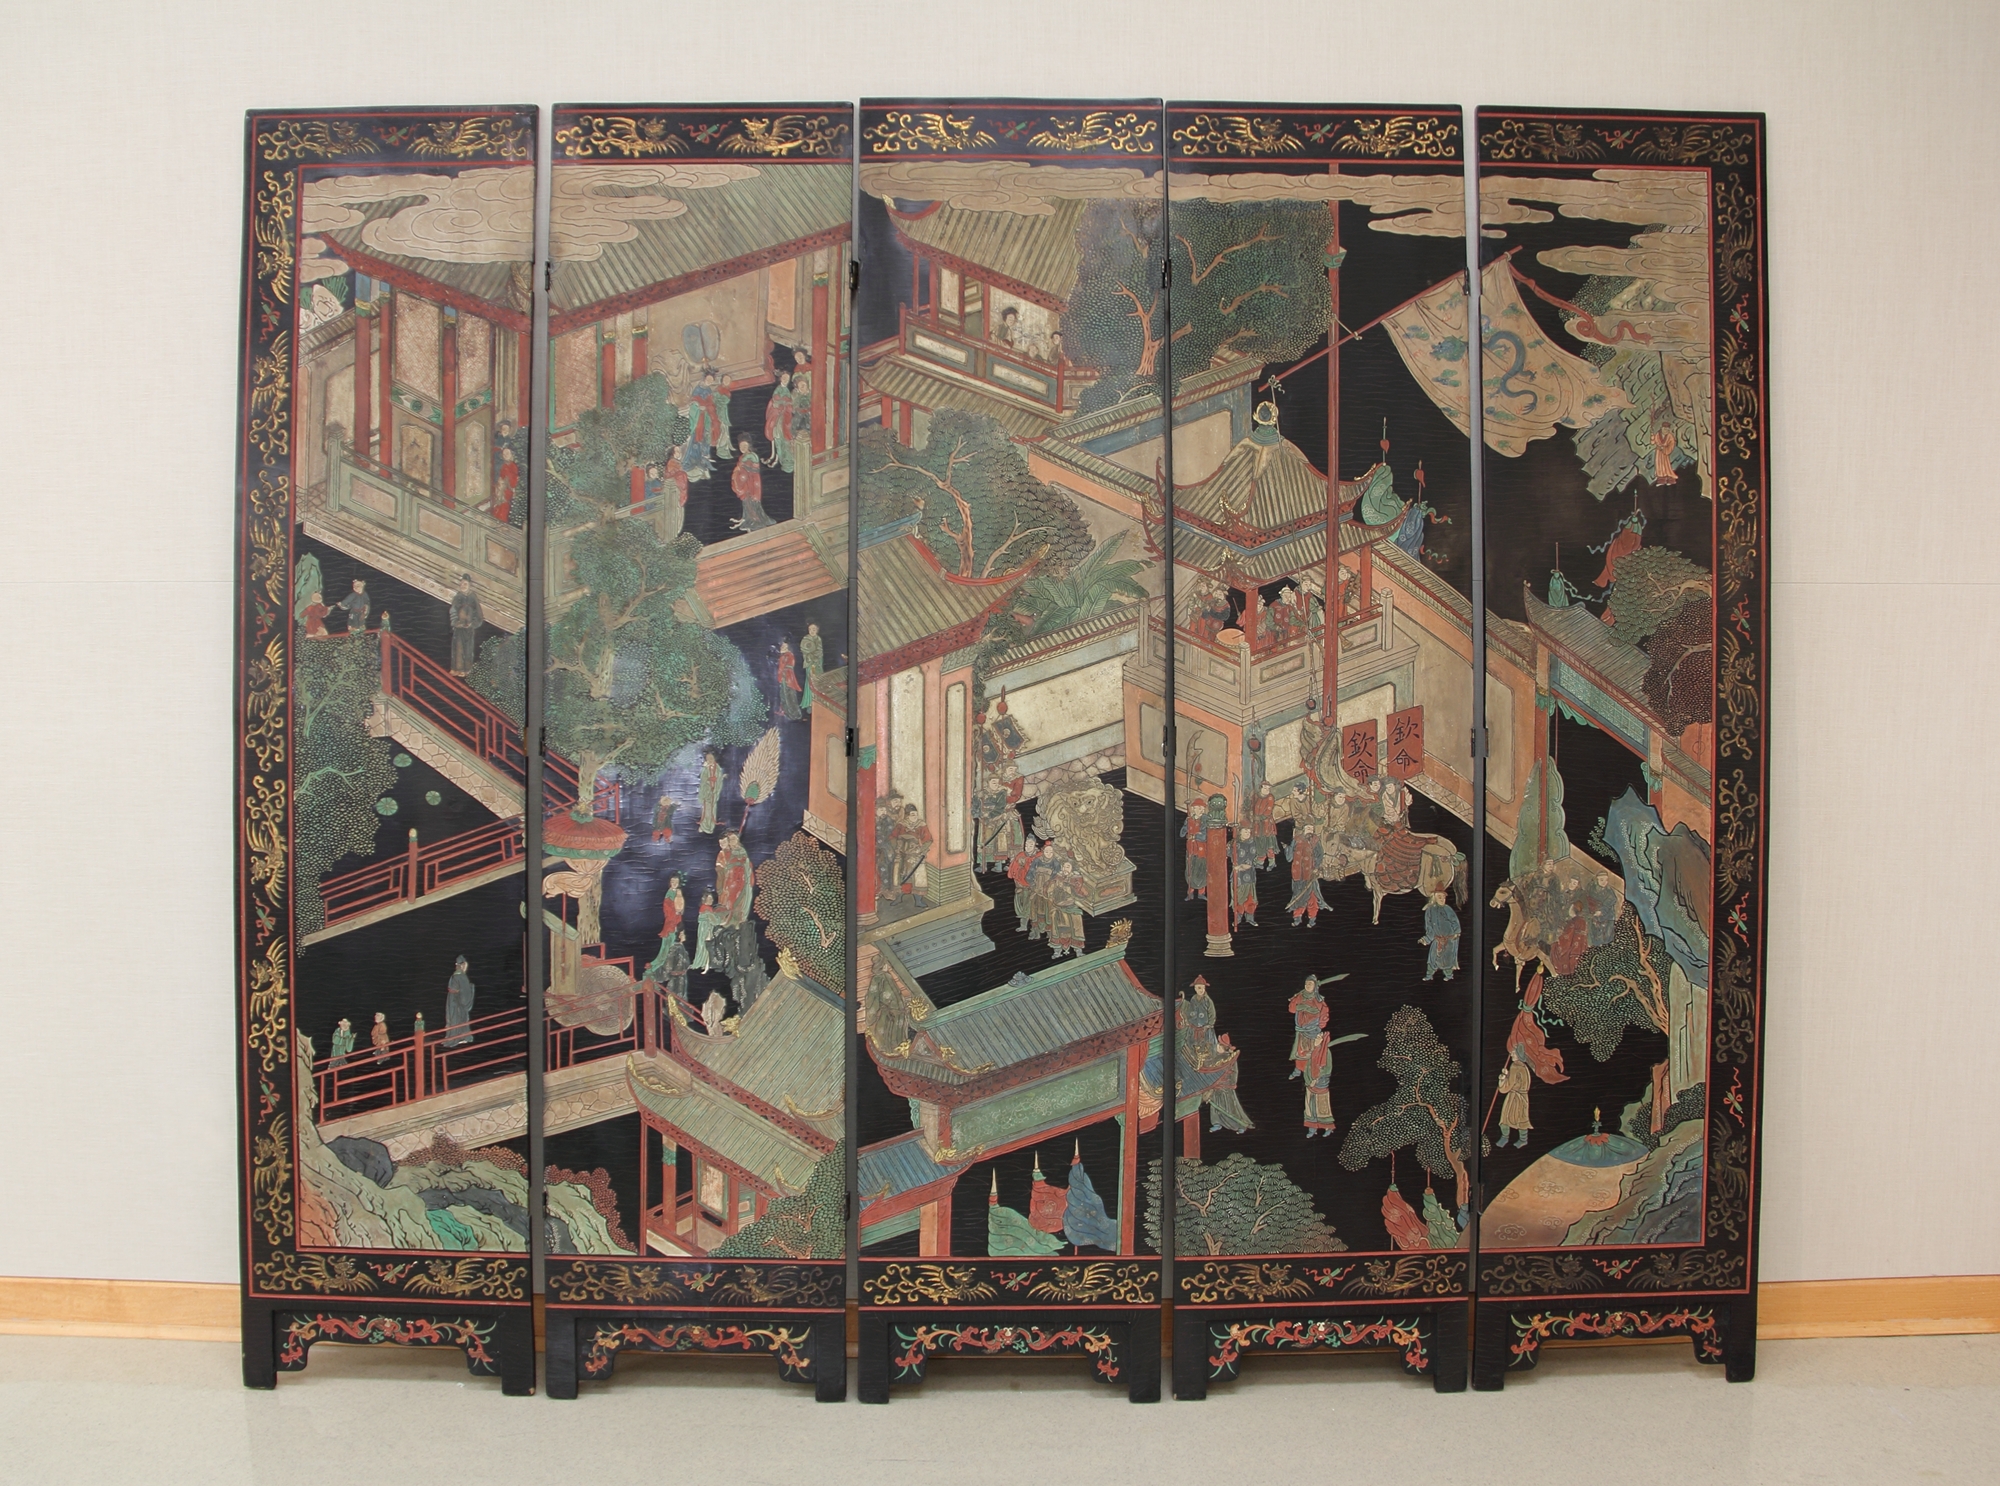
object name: screen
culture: chinese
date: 1676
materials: gold, lacquer, panel, wood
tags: women,horses,trees